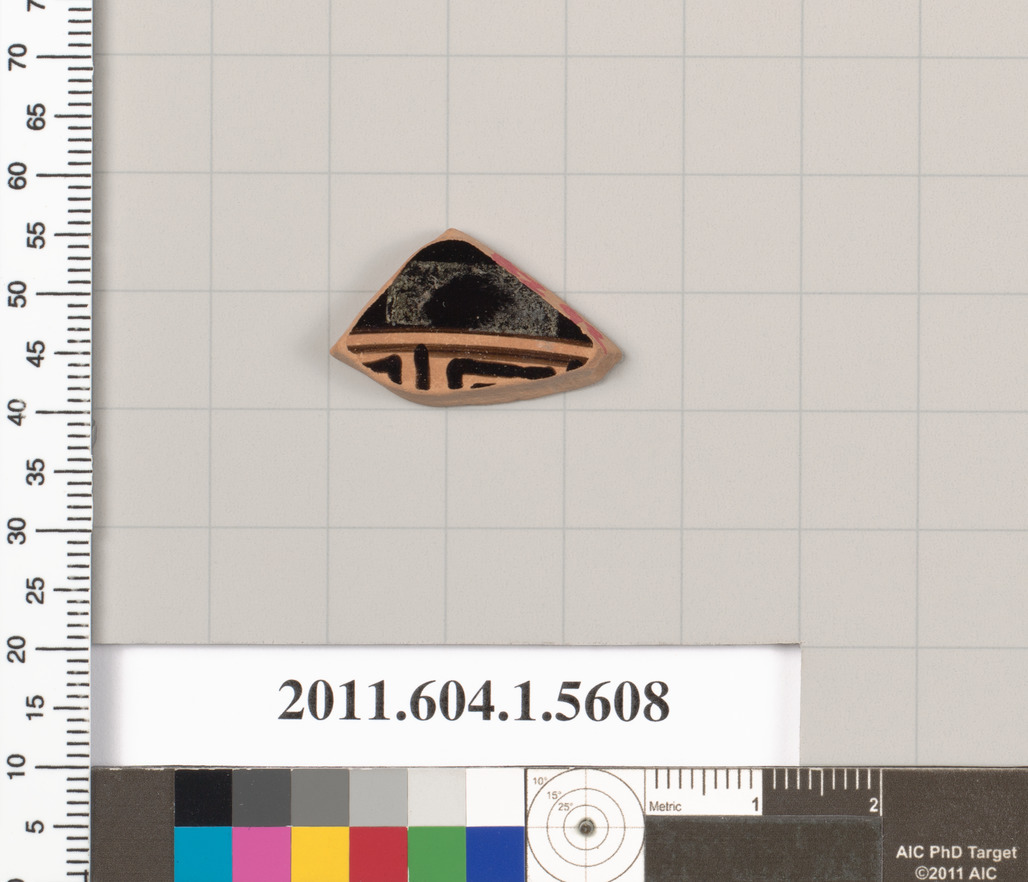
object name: kylix fragment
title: Terracotta fragment of a kylix (drinking cup)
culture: greek, attic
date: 510-490 BCE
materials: terracotta